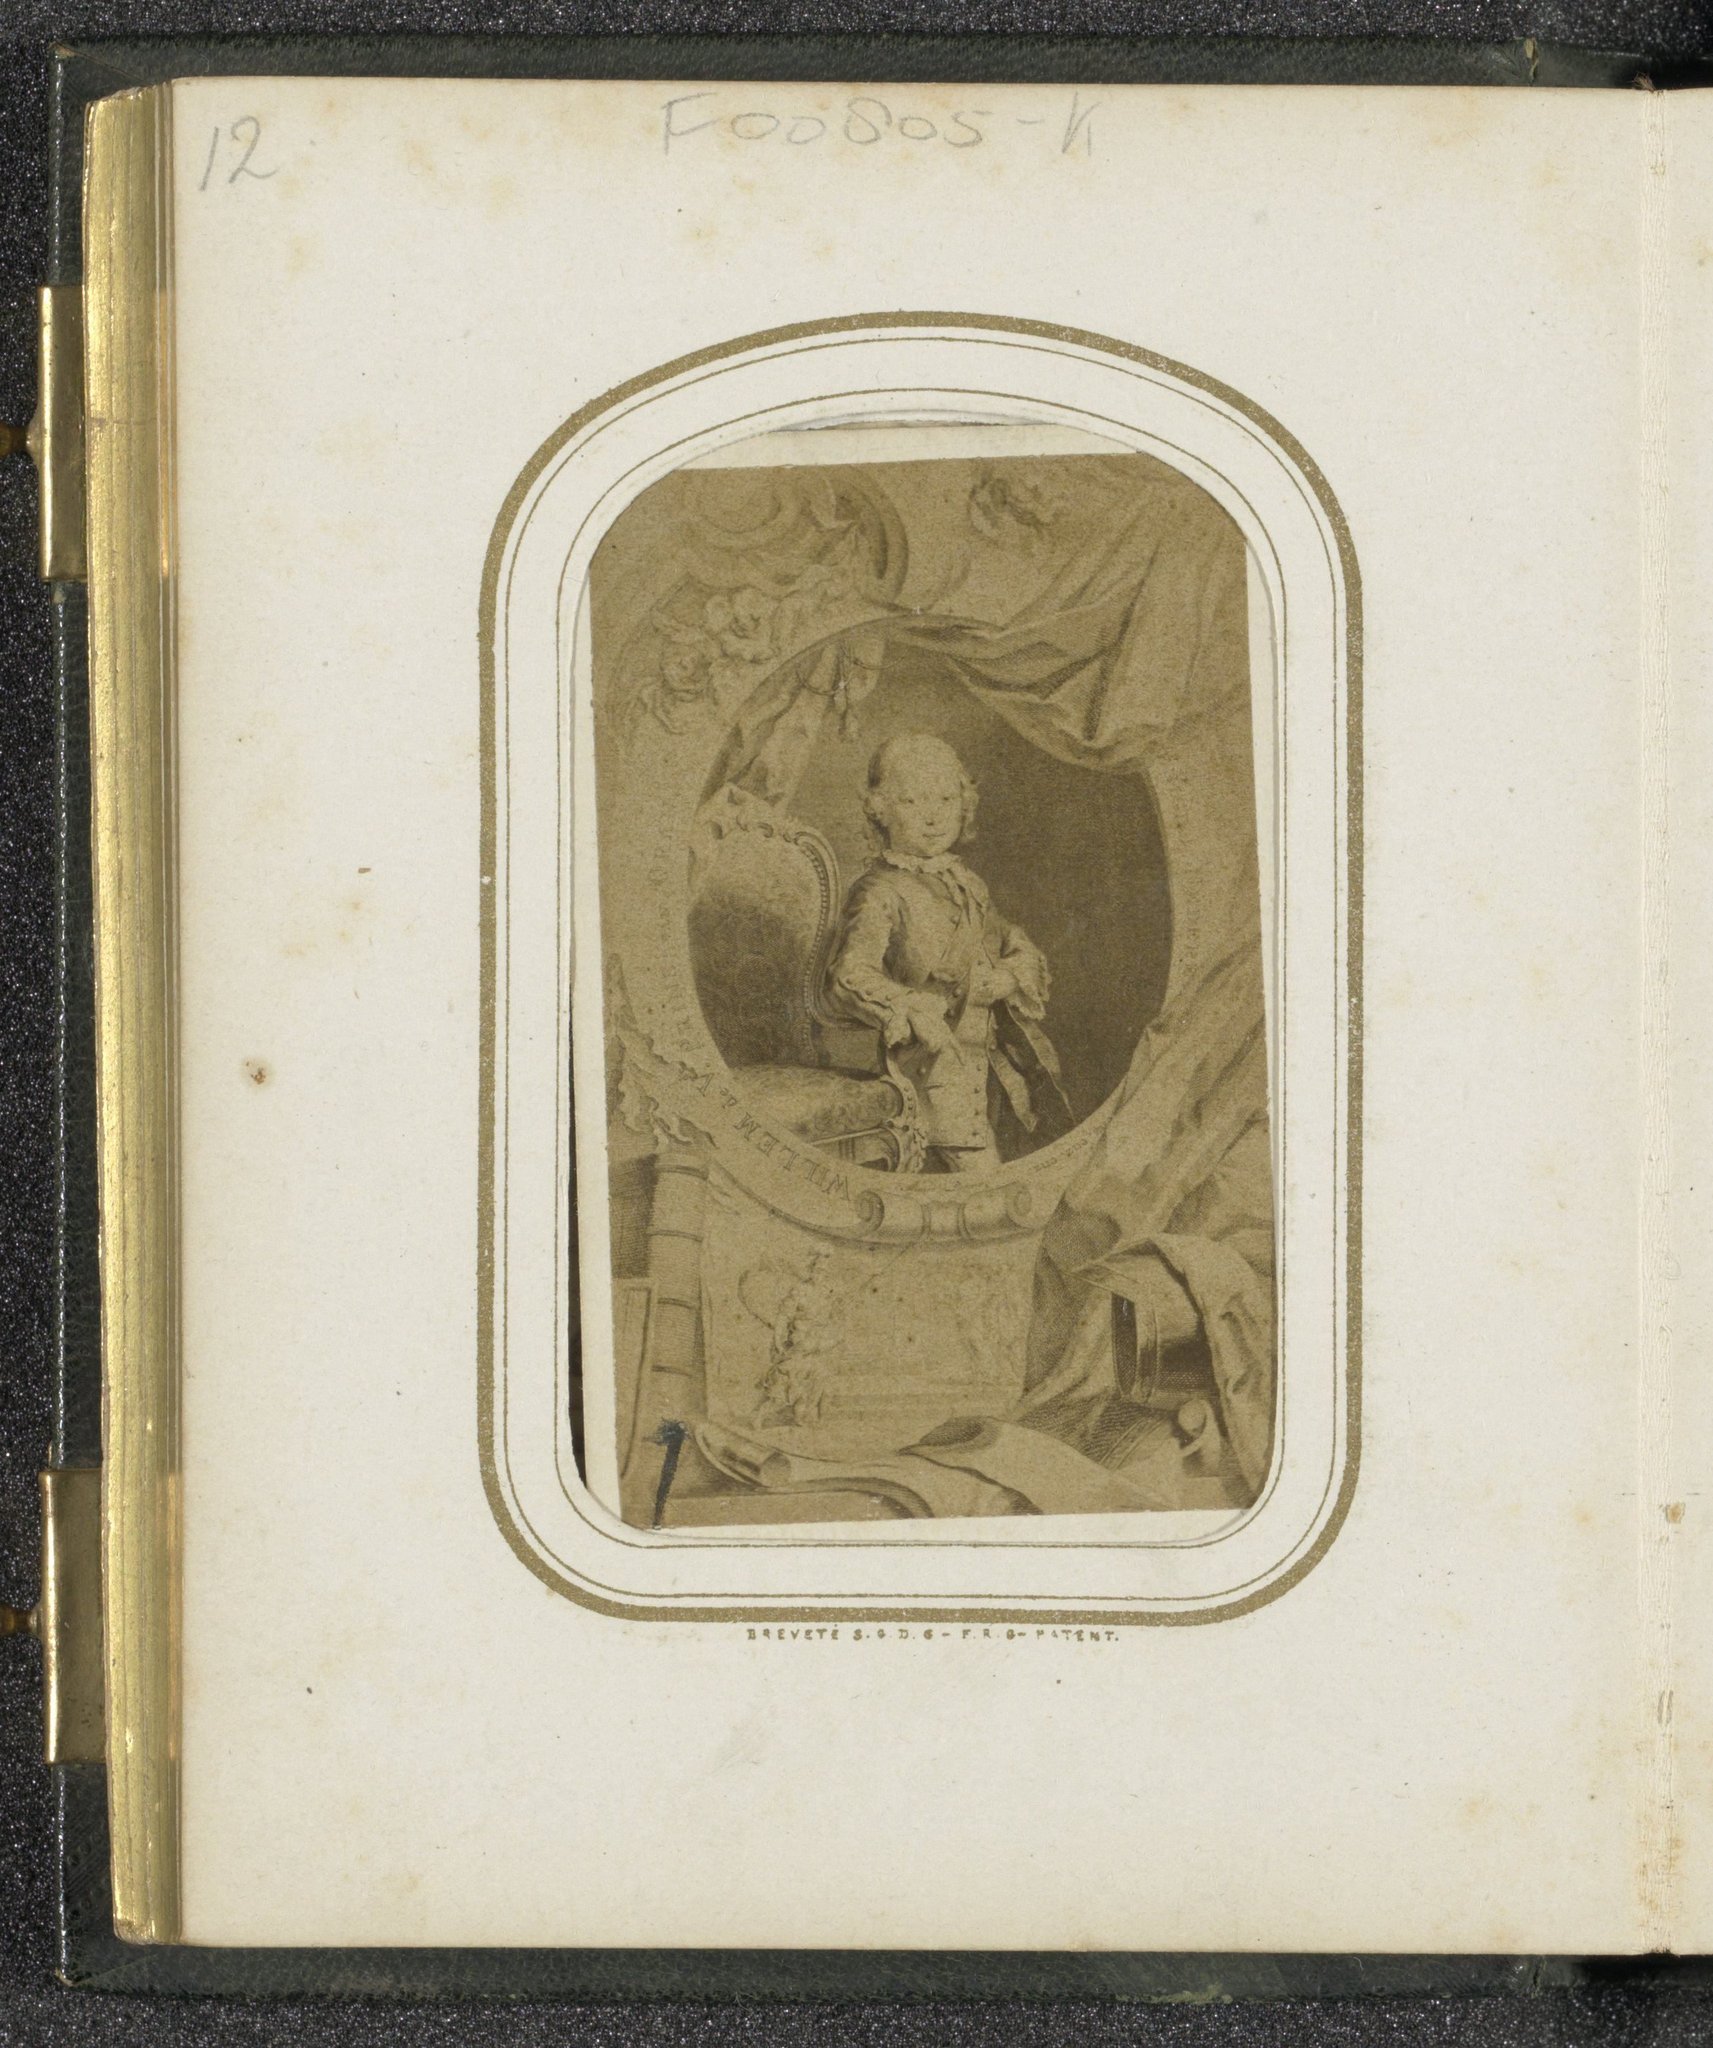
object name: reproduction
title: Fotoreproductie van (vermoedelijk) een prent van prins Willem V, prins van Oranje-Nassau, als kind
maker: Anonymous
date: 1860-1880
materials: cardboard, paper, photographic support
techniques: albumen print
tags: the hague, william v (prince of orange), armchair, seat, prince, child, historical persons, stadtholder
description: Onderdeel van Fotoalbum met 29 foto's van Nederlandse vorsten.